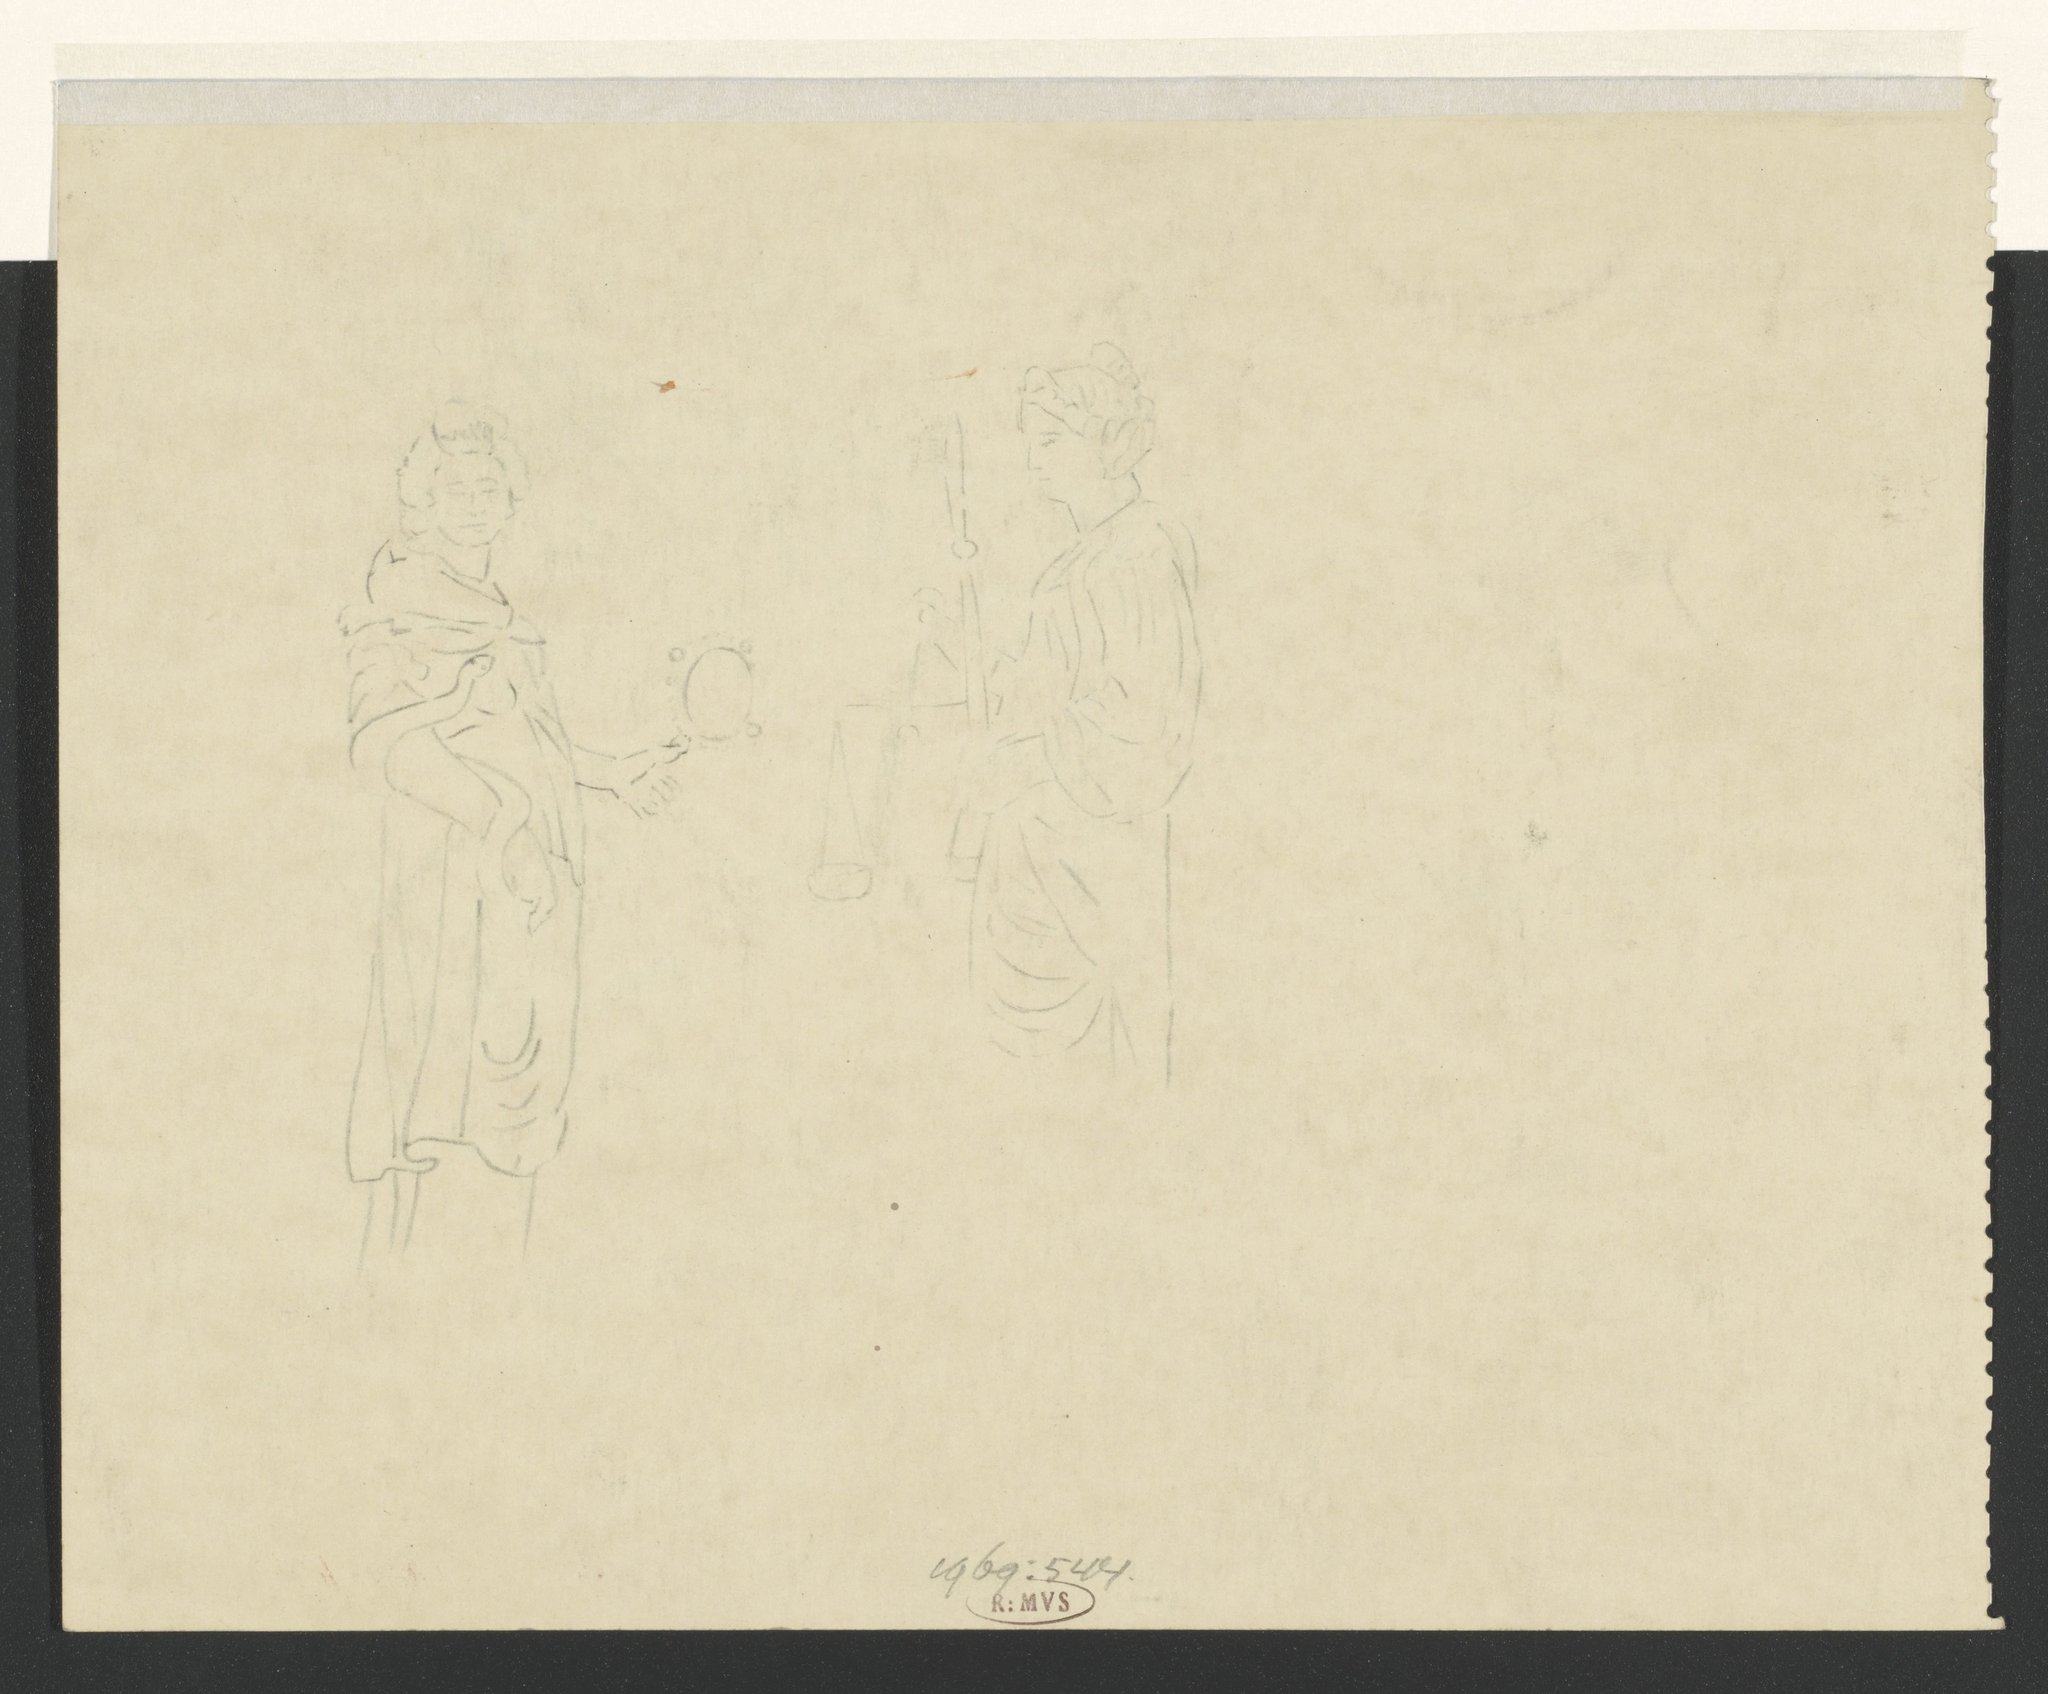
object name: drawing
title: Prudentia en Justitia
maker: carel adolph lion cachet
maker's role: draughtsman, print maker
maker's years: 1864-1945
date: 1874-1945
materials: paper, pencil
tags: justice, 'justitia'; 'giustitia divina' (ripa) ~ one of the four cardinal virtues, prudence, 'prudentia'; 'prudenza' (ripa) ~ one of the four cardinal virtues